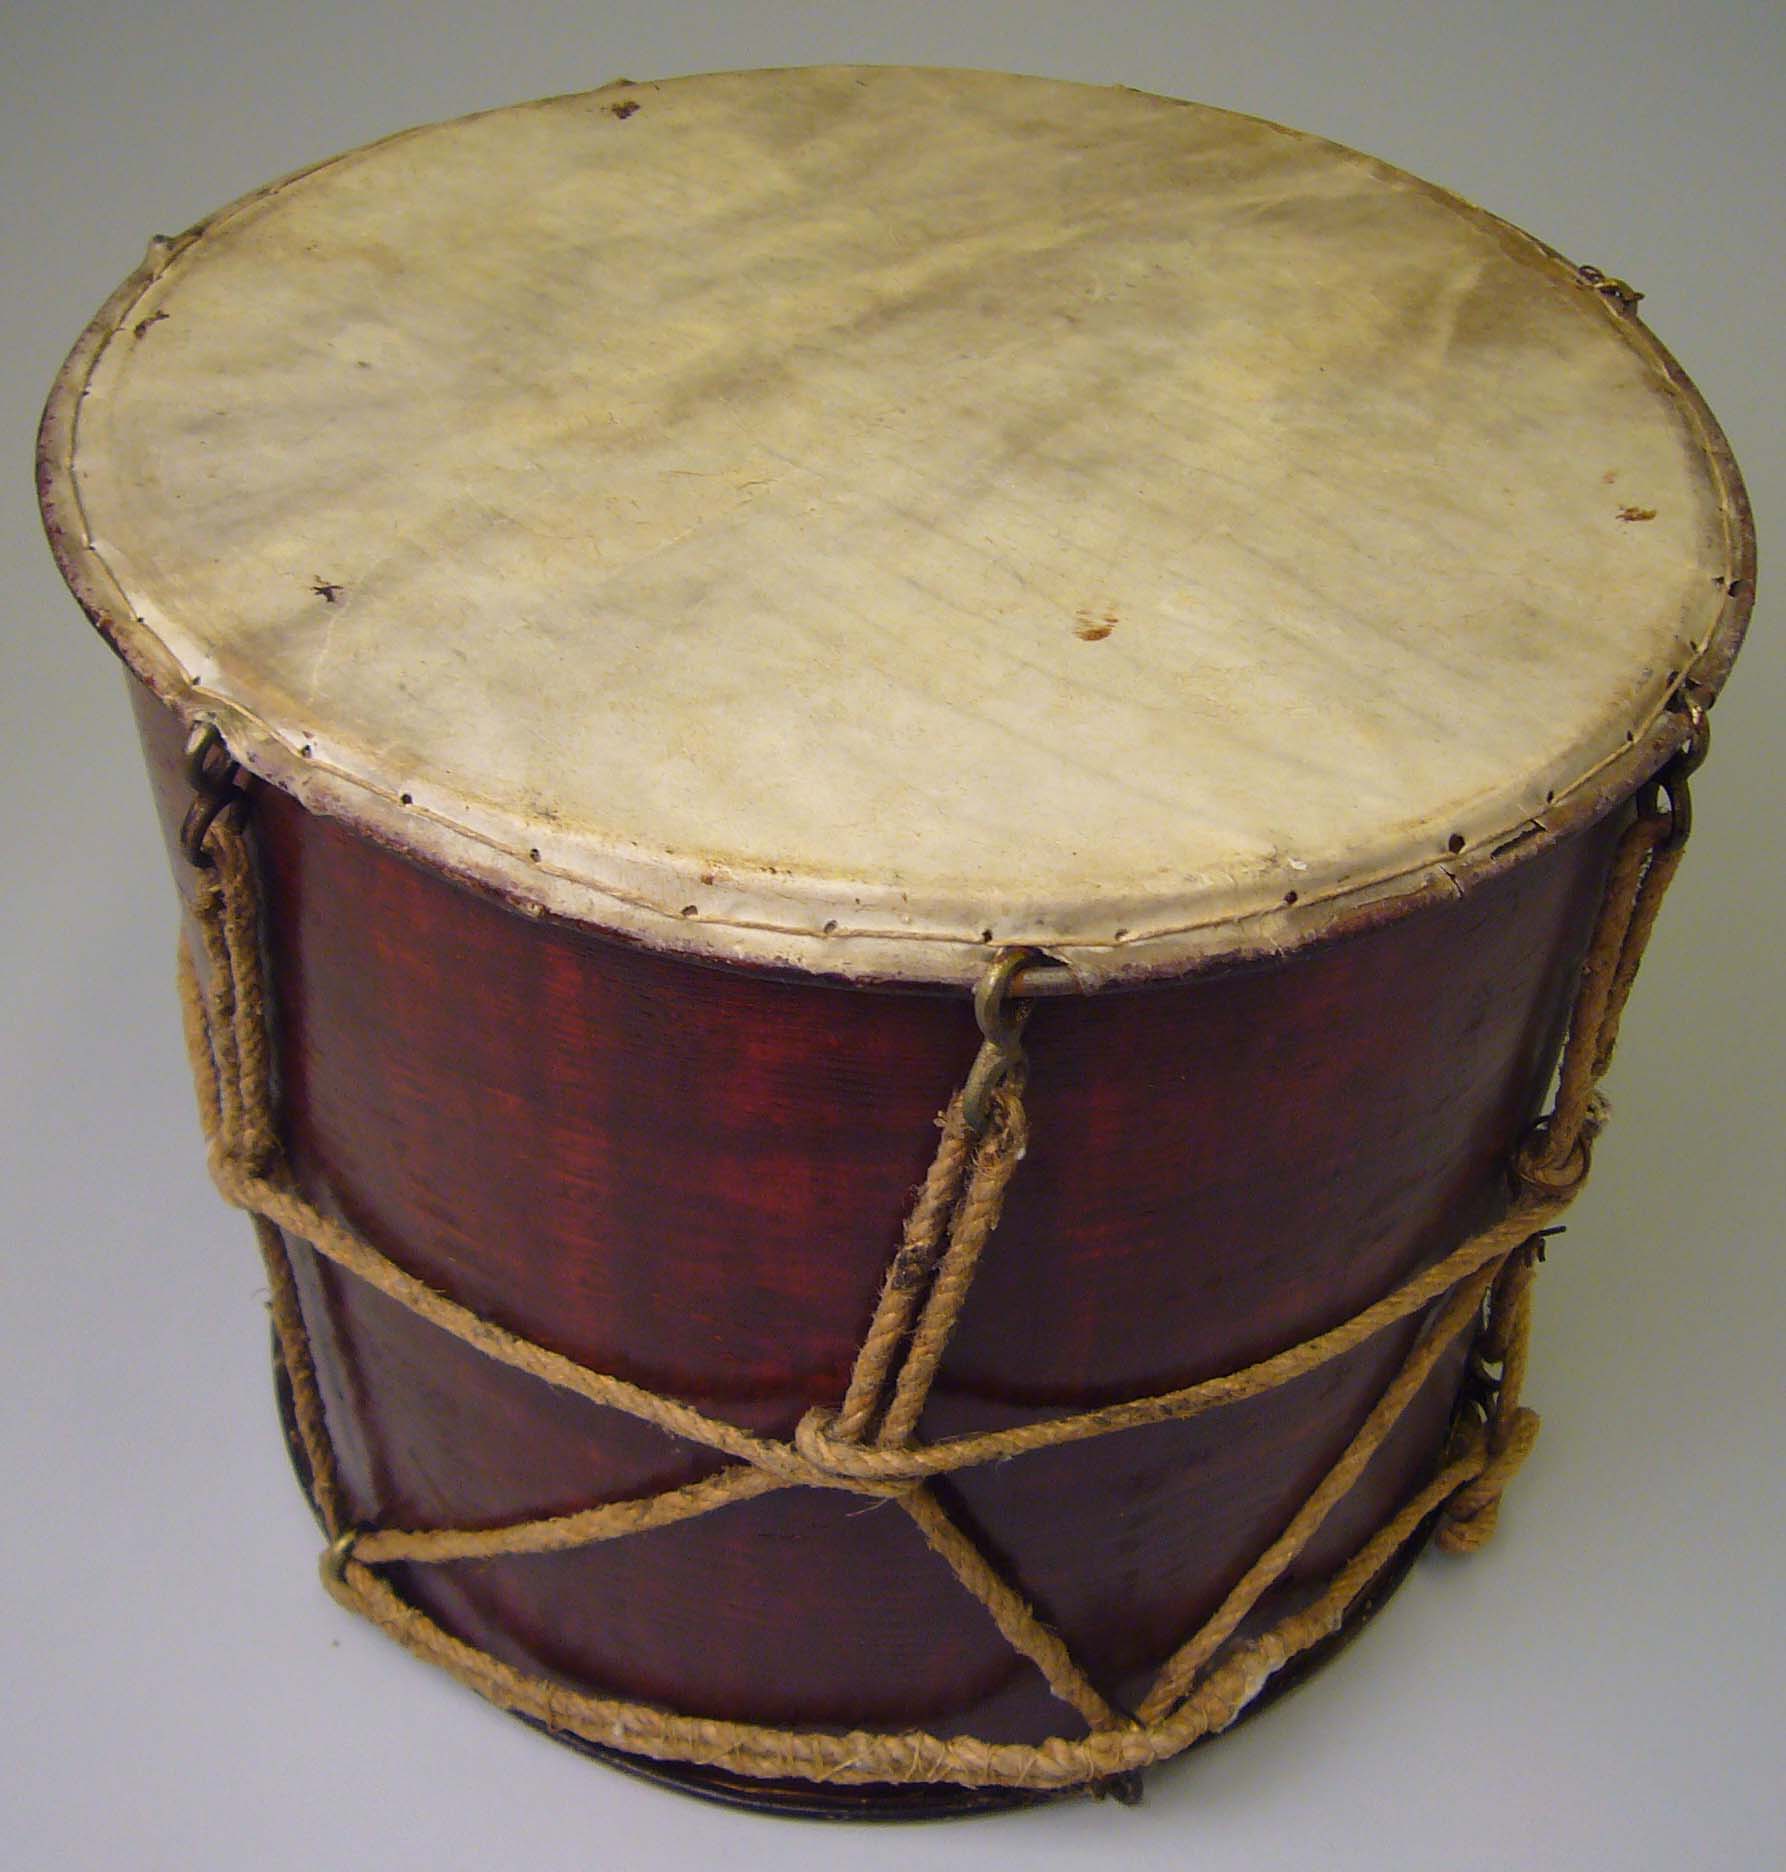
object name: drum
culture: russian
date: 1801-1900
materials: skin, wood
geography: russia